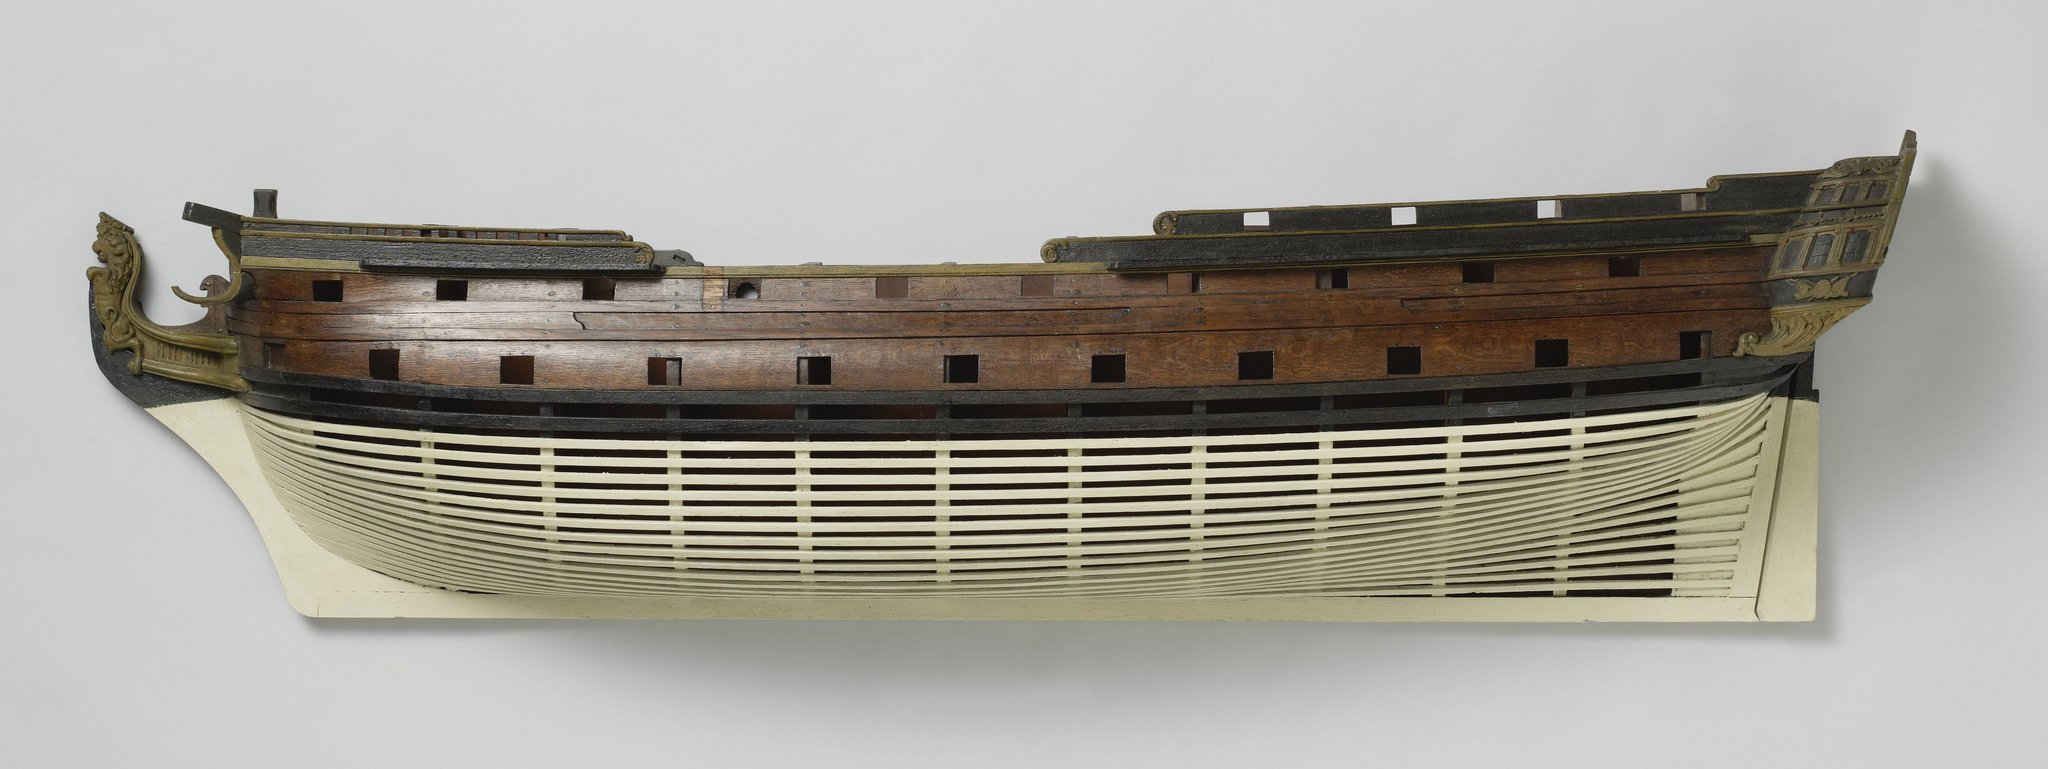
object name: builder's model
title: Half Model of a 54-Gun Ship of the Line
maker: Anonymous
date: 1782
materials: wood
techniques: polychromy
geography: netherlands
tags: zeeland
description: Gepolychromeerd mallenmodel (bakboord) op kleine achterplaat. De huid boven het berghout is gesloten. Vijf en twintig geschutpoorten op twee dekken; bakdek en bovenkampanje door gillingen aangegeven. Het schegbeeld is een gekroonde leeuw. Gewrongen spiegel, hol wulf, hek en zijgalerij van twee verdiepingen, met verguld snijwerk van wapentrofeeën en lofwerk. Onder het hek een lege rechthoekige cartouche. Recht roer met vierkante roerkoning in groot rond hennegat met versierde rand. Zeeg naar achteren oplopend, twee berghouten en één reehout. Gepiekt rondspant.